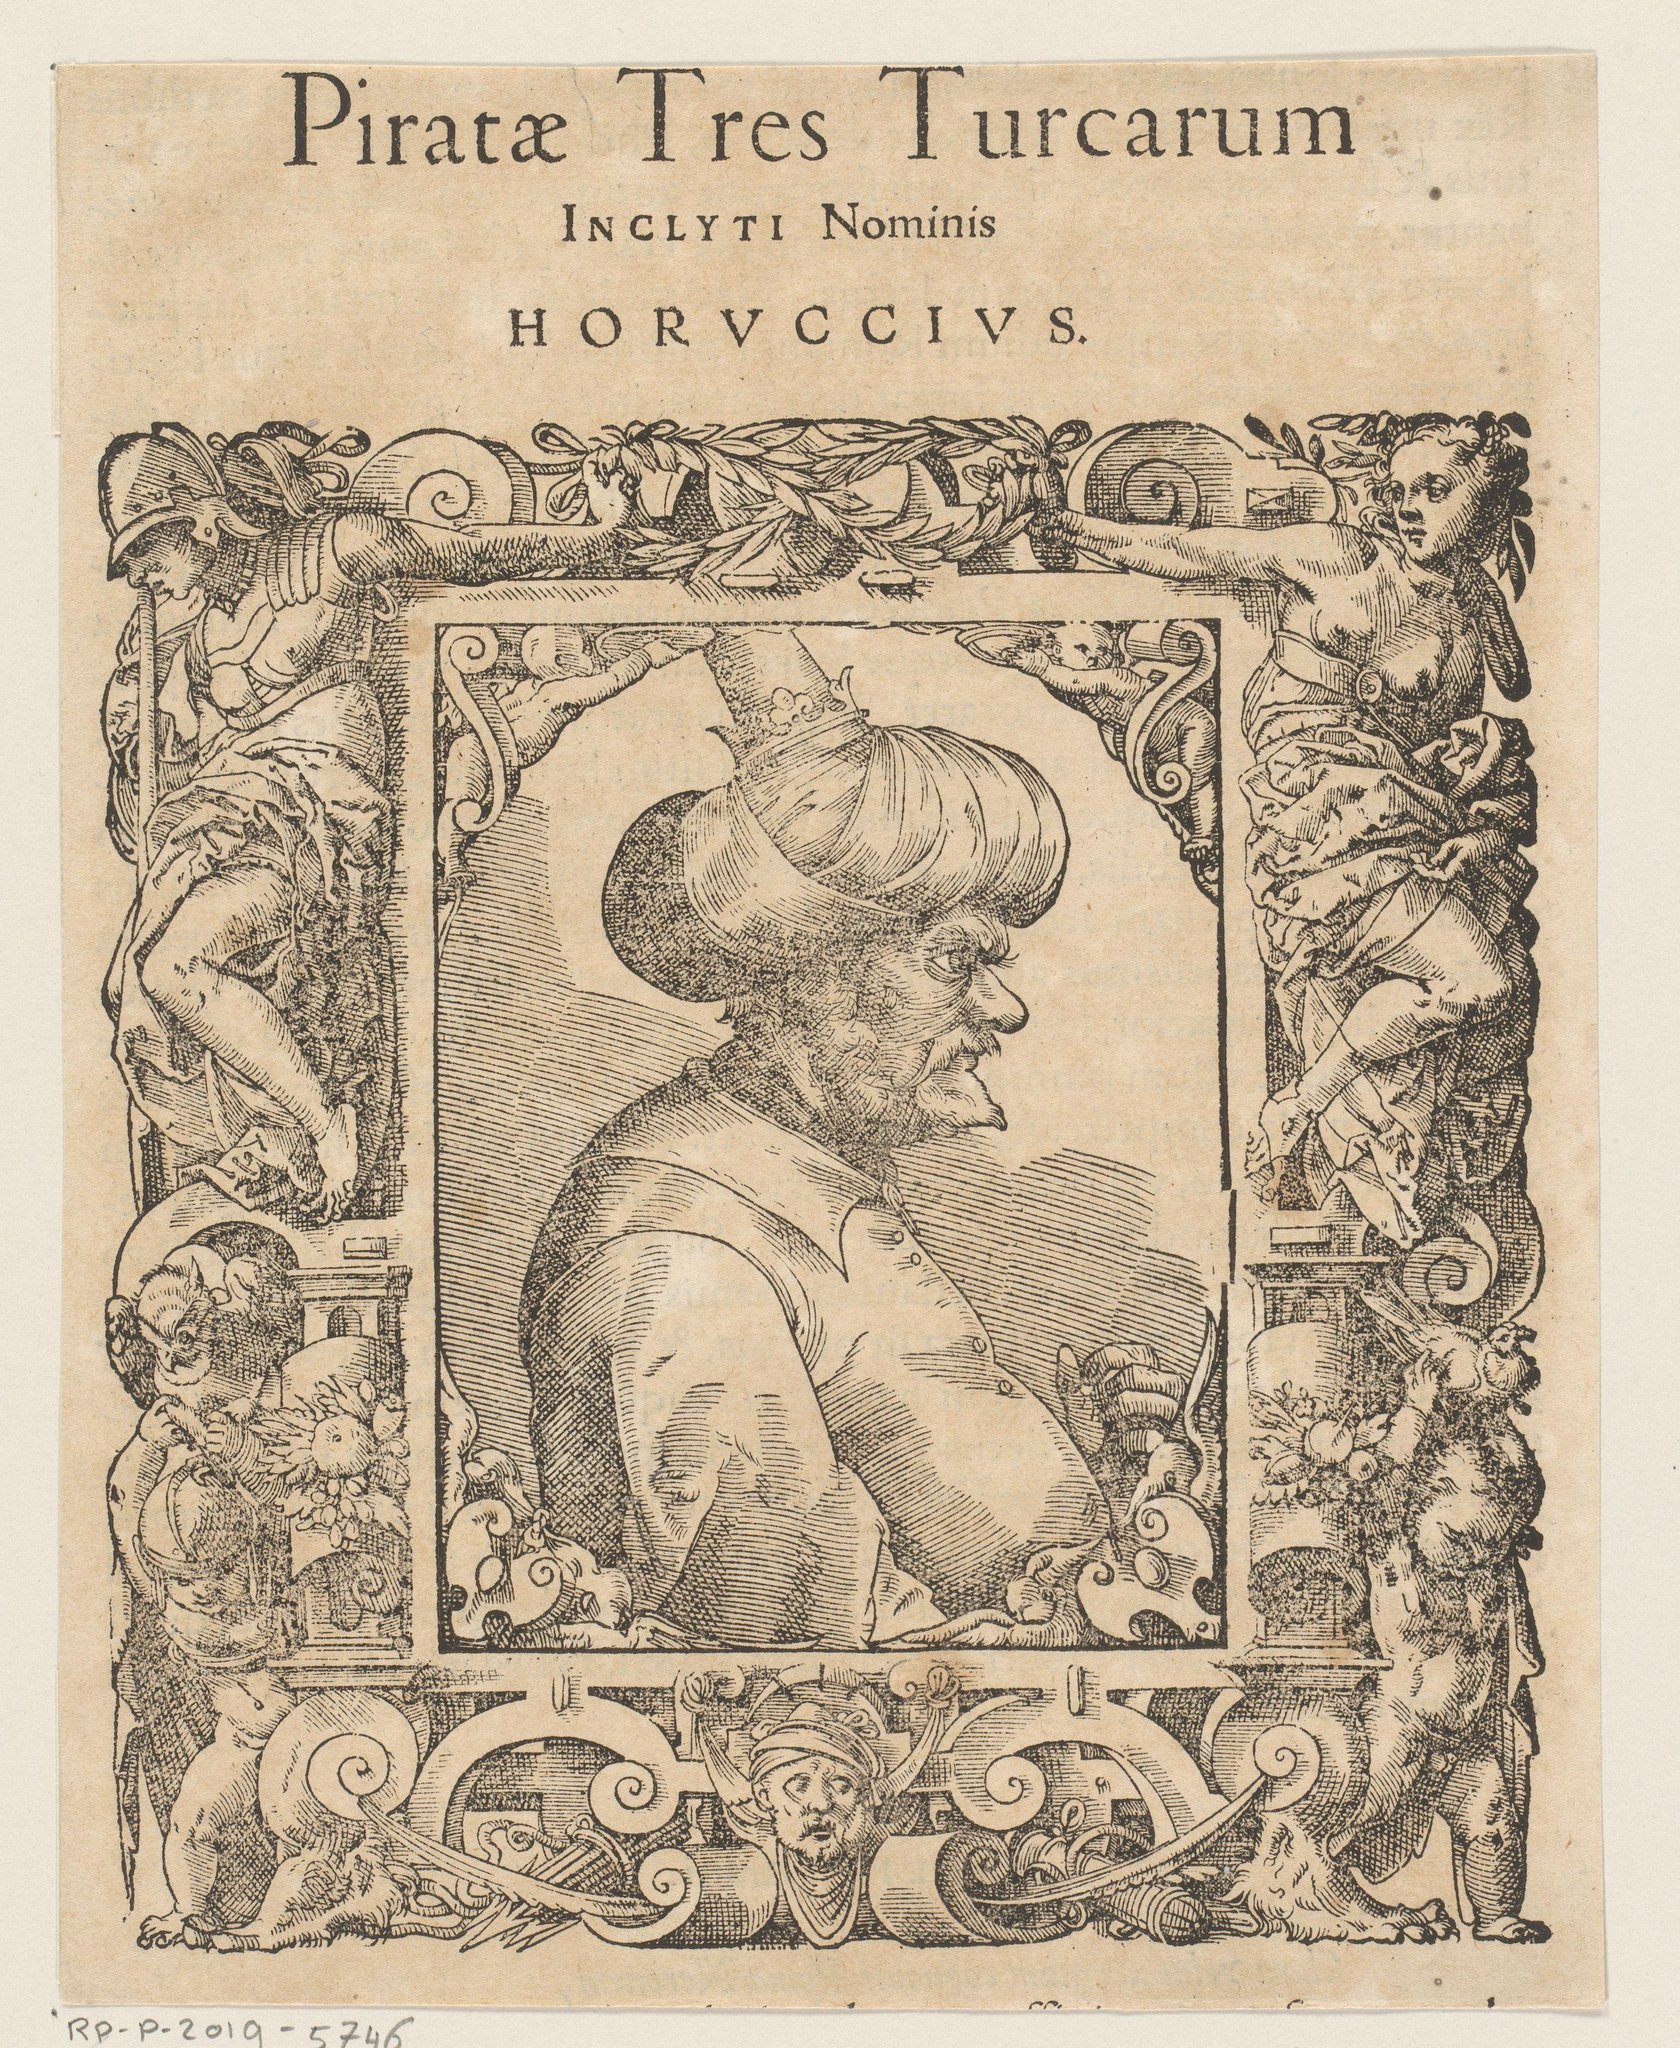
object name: book illustration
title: Portret van Oruç Reis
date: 1575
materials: paper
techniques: letterpress printing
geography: basel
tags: historical persons, head-gear: turban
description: Prent uit: Giovio, Paolo. Elogia virorum bellica virtute illustrium (...). Bazel: Peter Perna, 1575, p. 340. Prent ook gebruikt in latere publicaties.